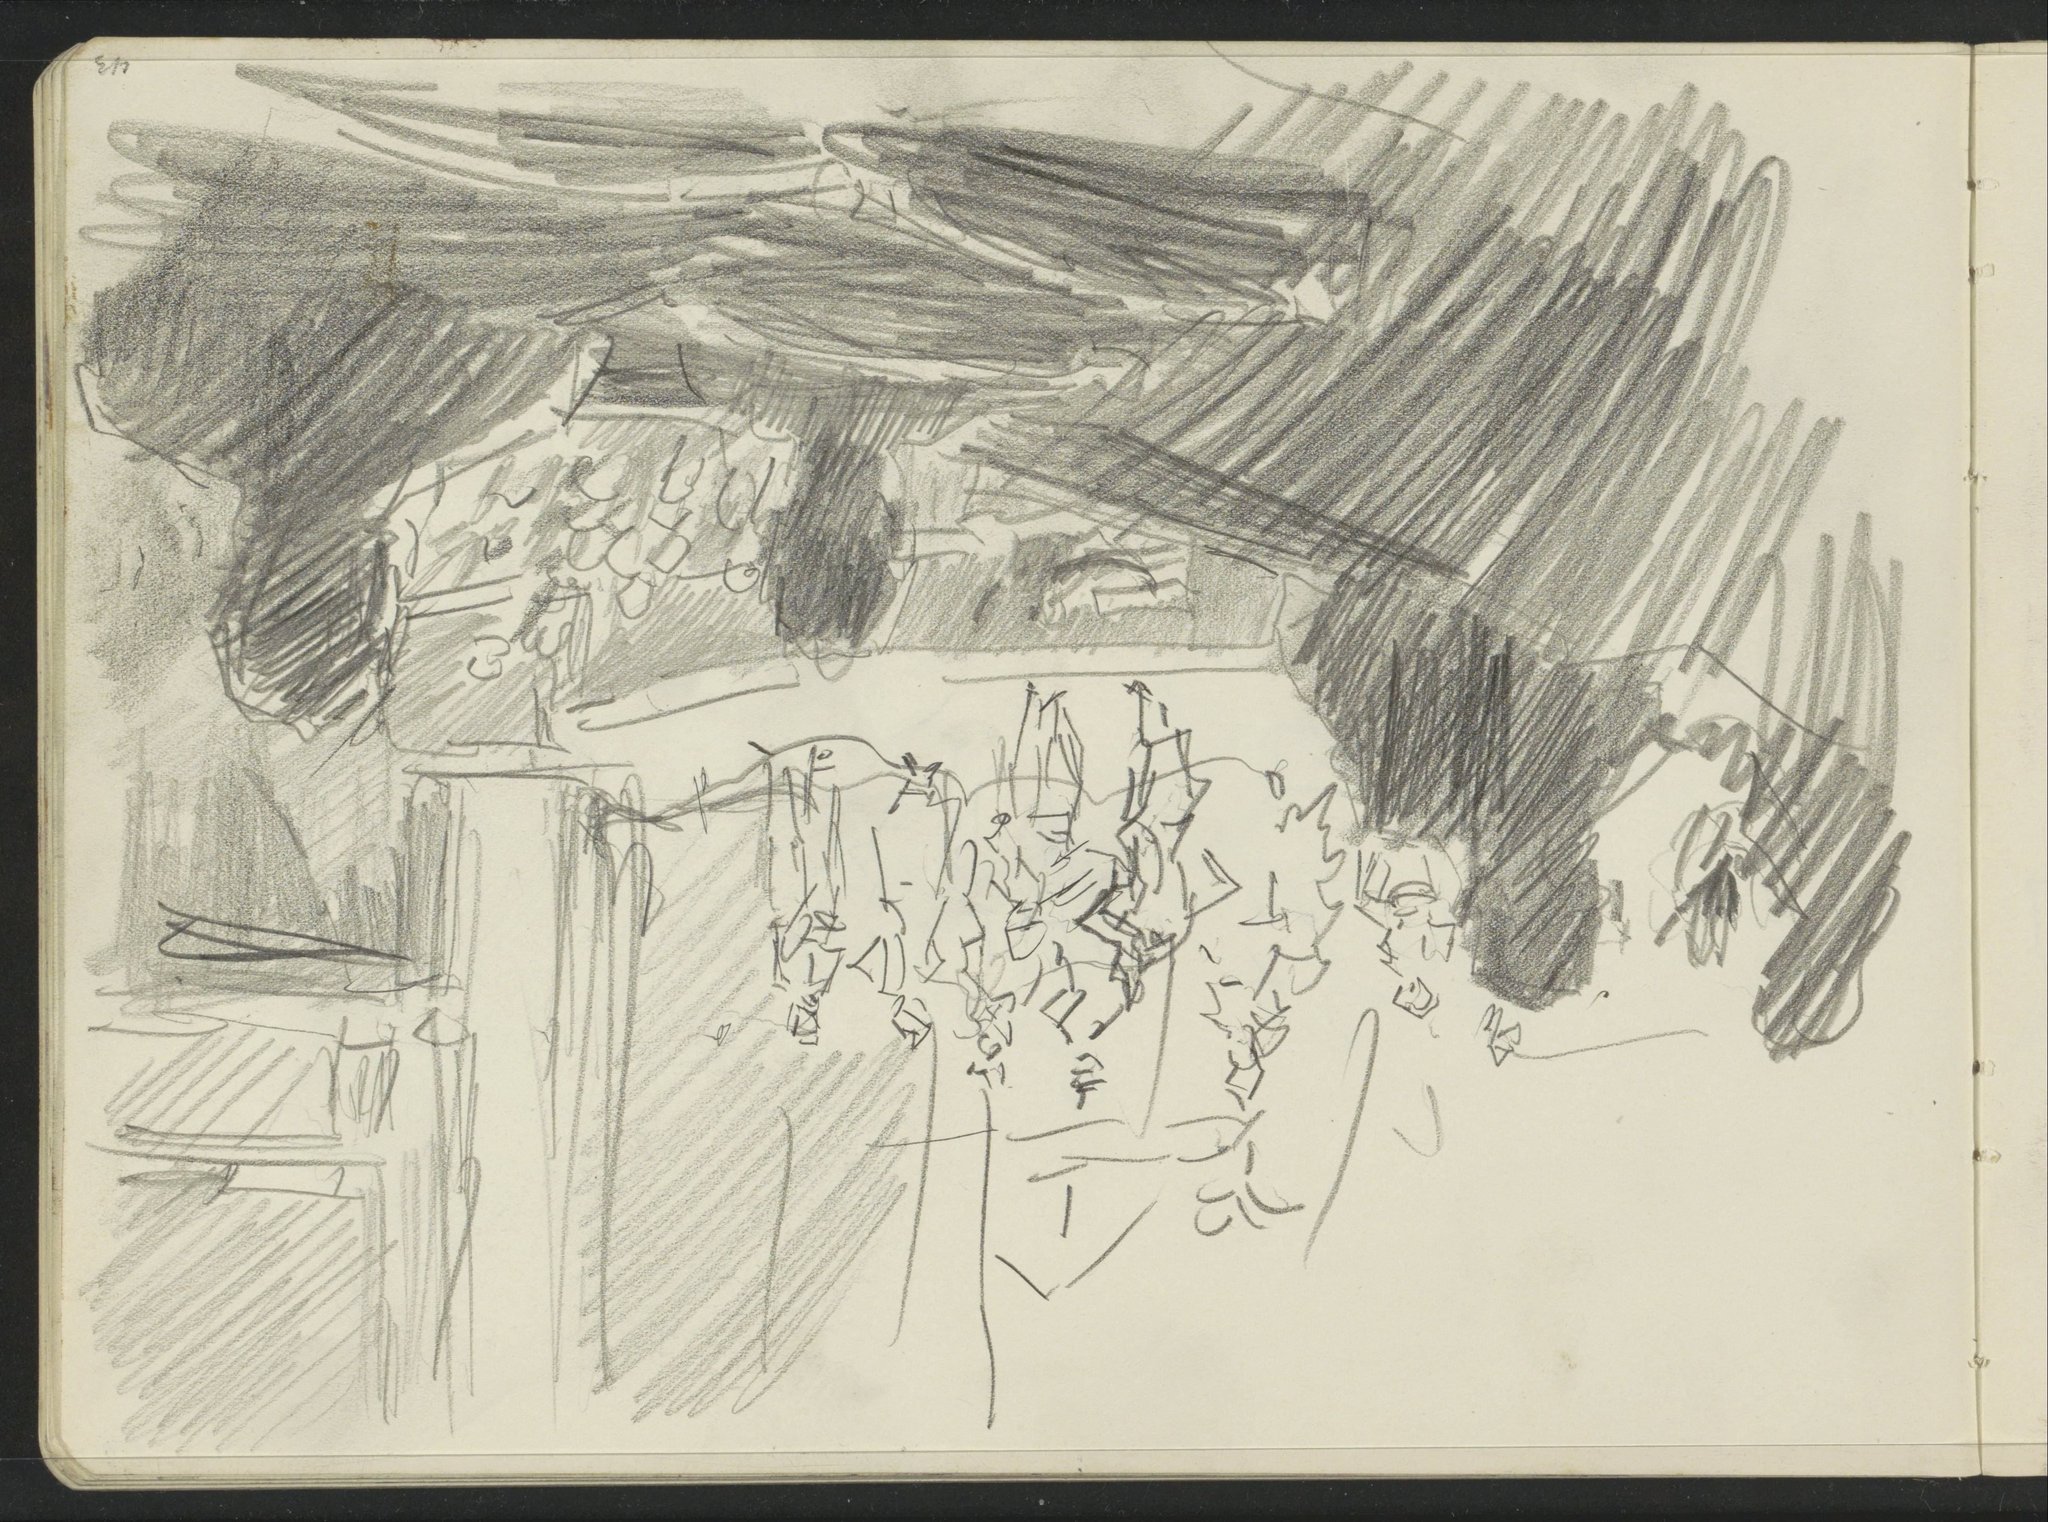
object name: sketchbook leaf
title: Theatervoorstelling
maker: isaac israels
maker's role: draughtsman, painter, print maker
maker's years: 1865-1934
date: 1915-1934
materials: paper, pencil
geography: the hague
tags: boxes, loges ~ theatre, etc., the audience ~ art performance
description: Vooraan toeschouwers op een balkon, op de rug gezien. Blad 28 verso uit schetsboek XVIII met 35 bladen.